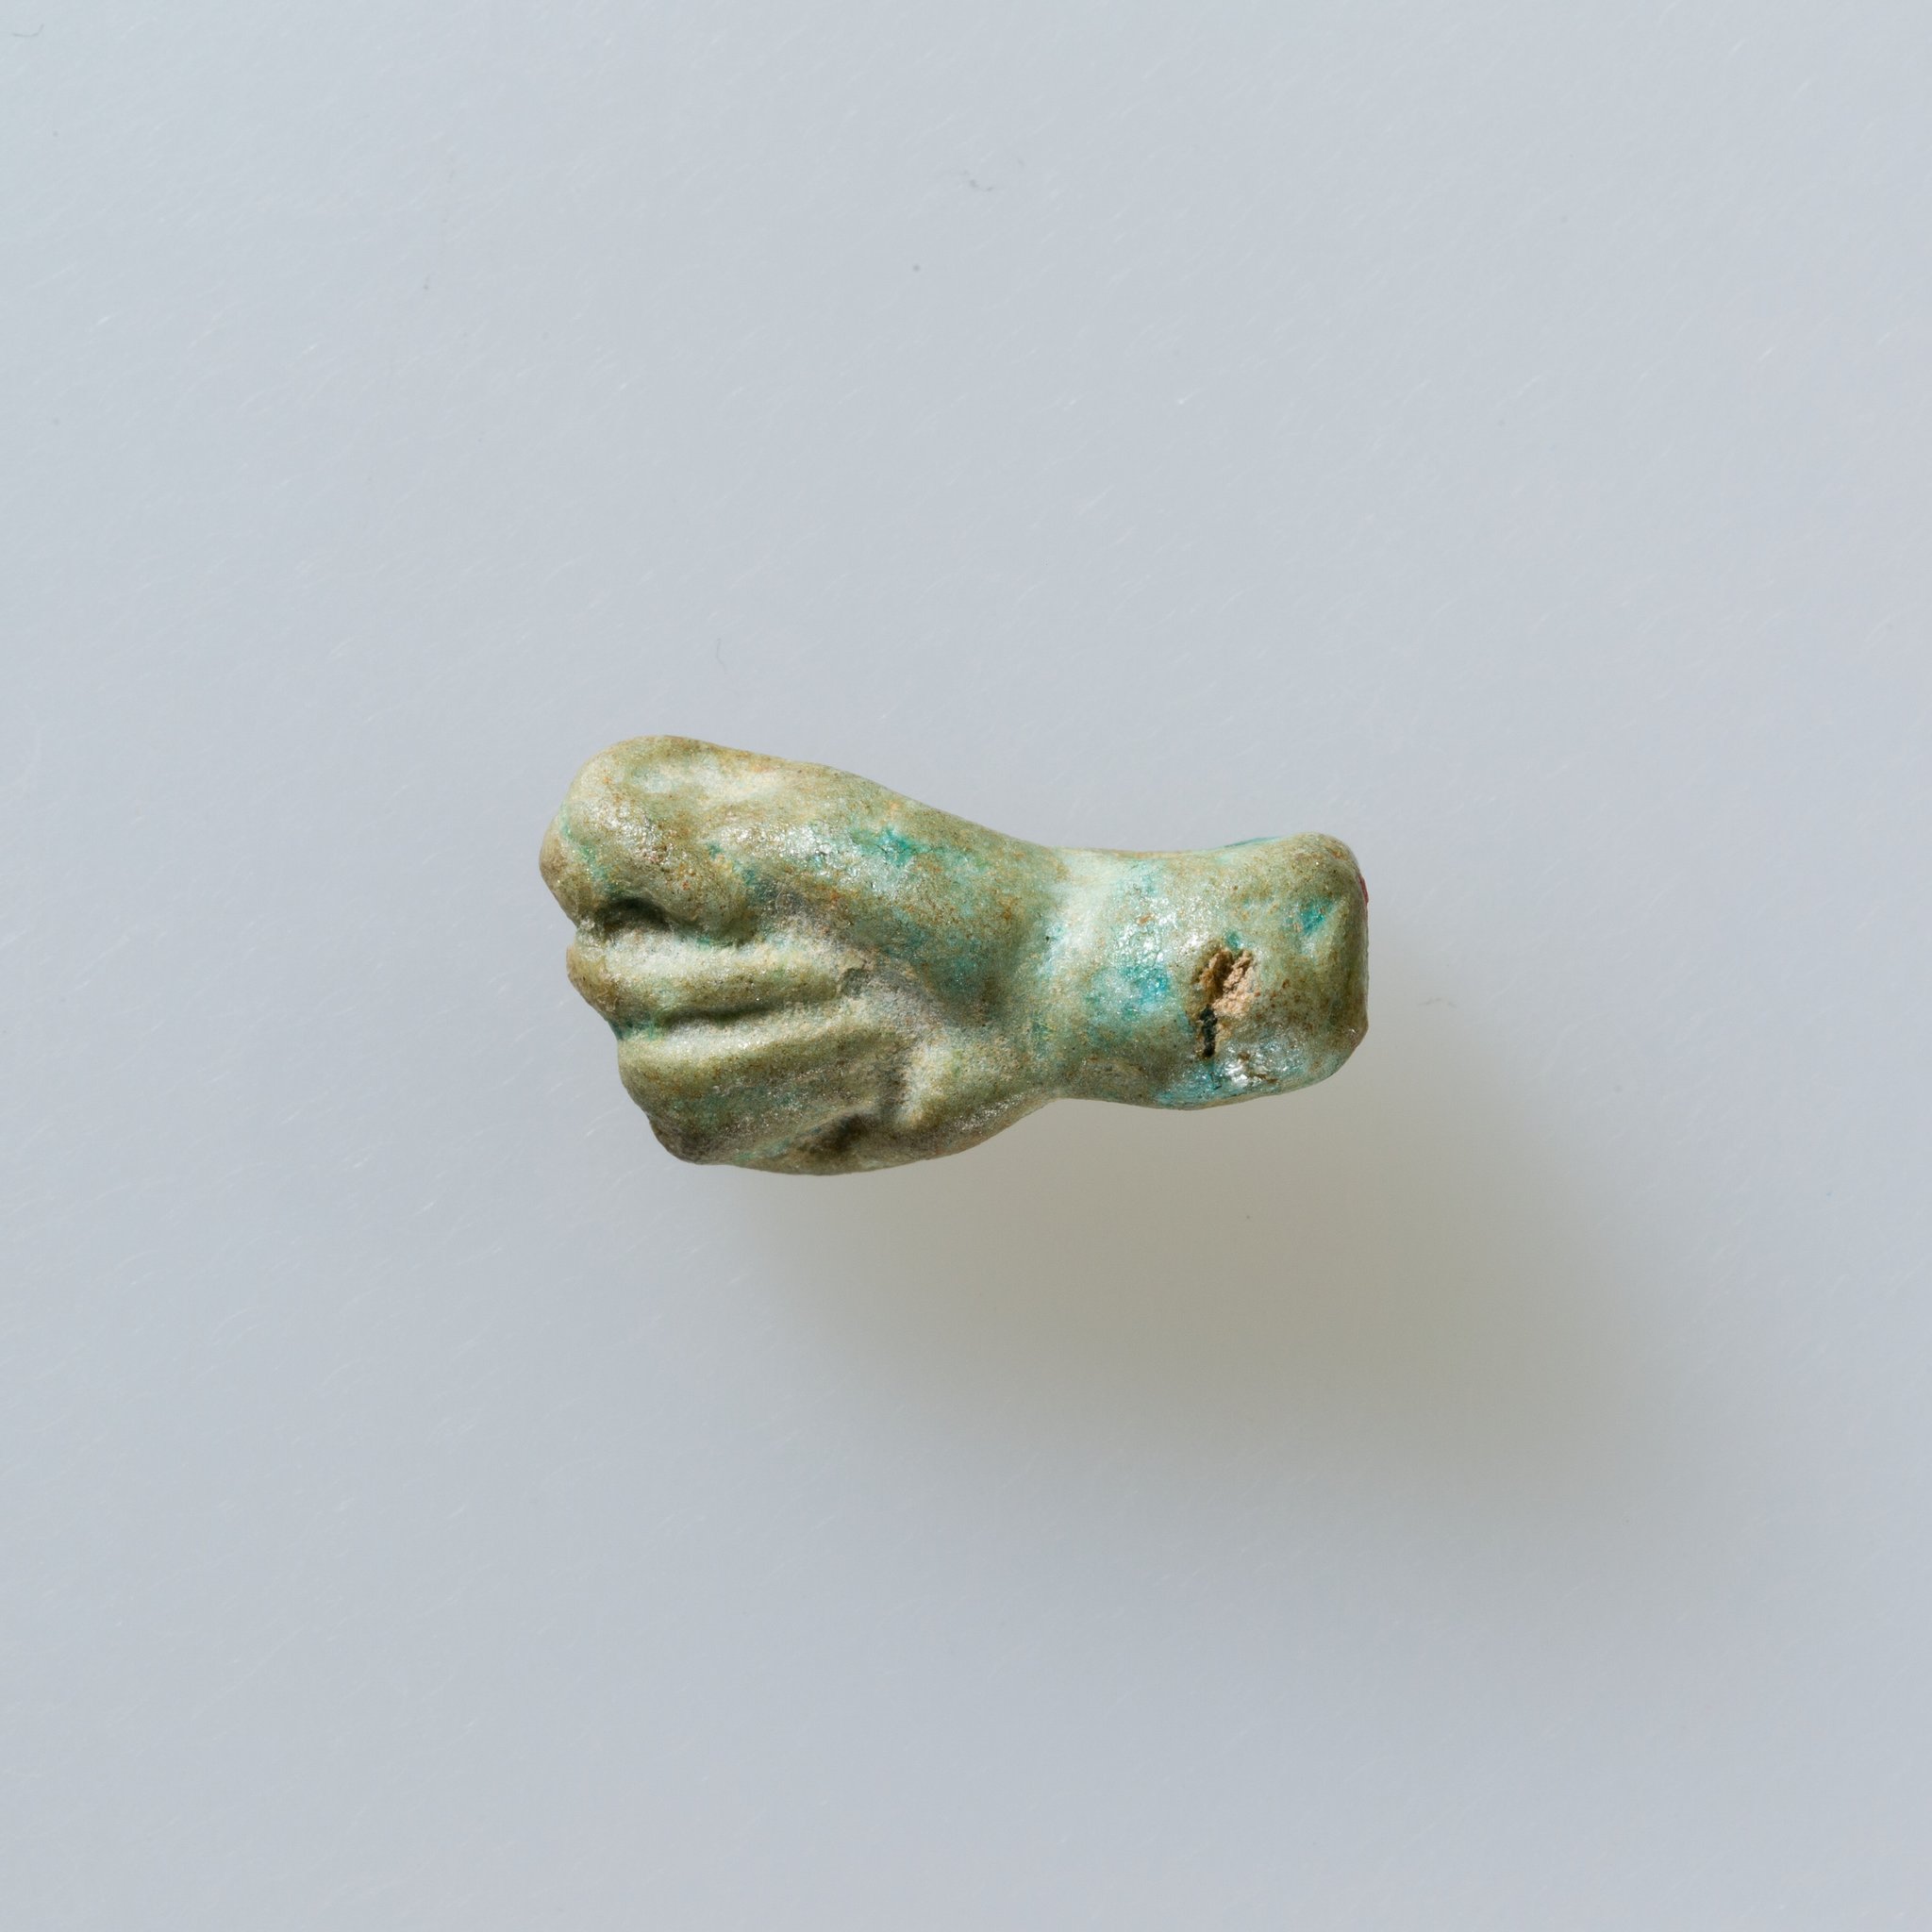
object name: amulet, fist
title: Amulet of fist with thumb thrust between first two fingers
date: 1-366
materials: faience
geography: egypt